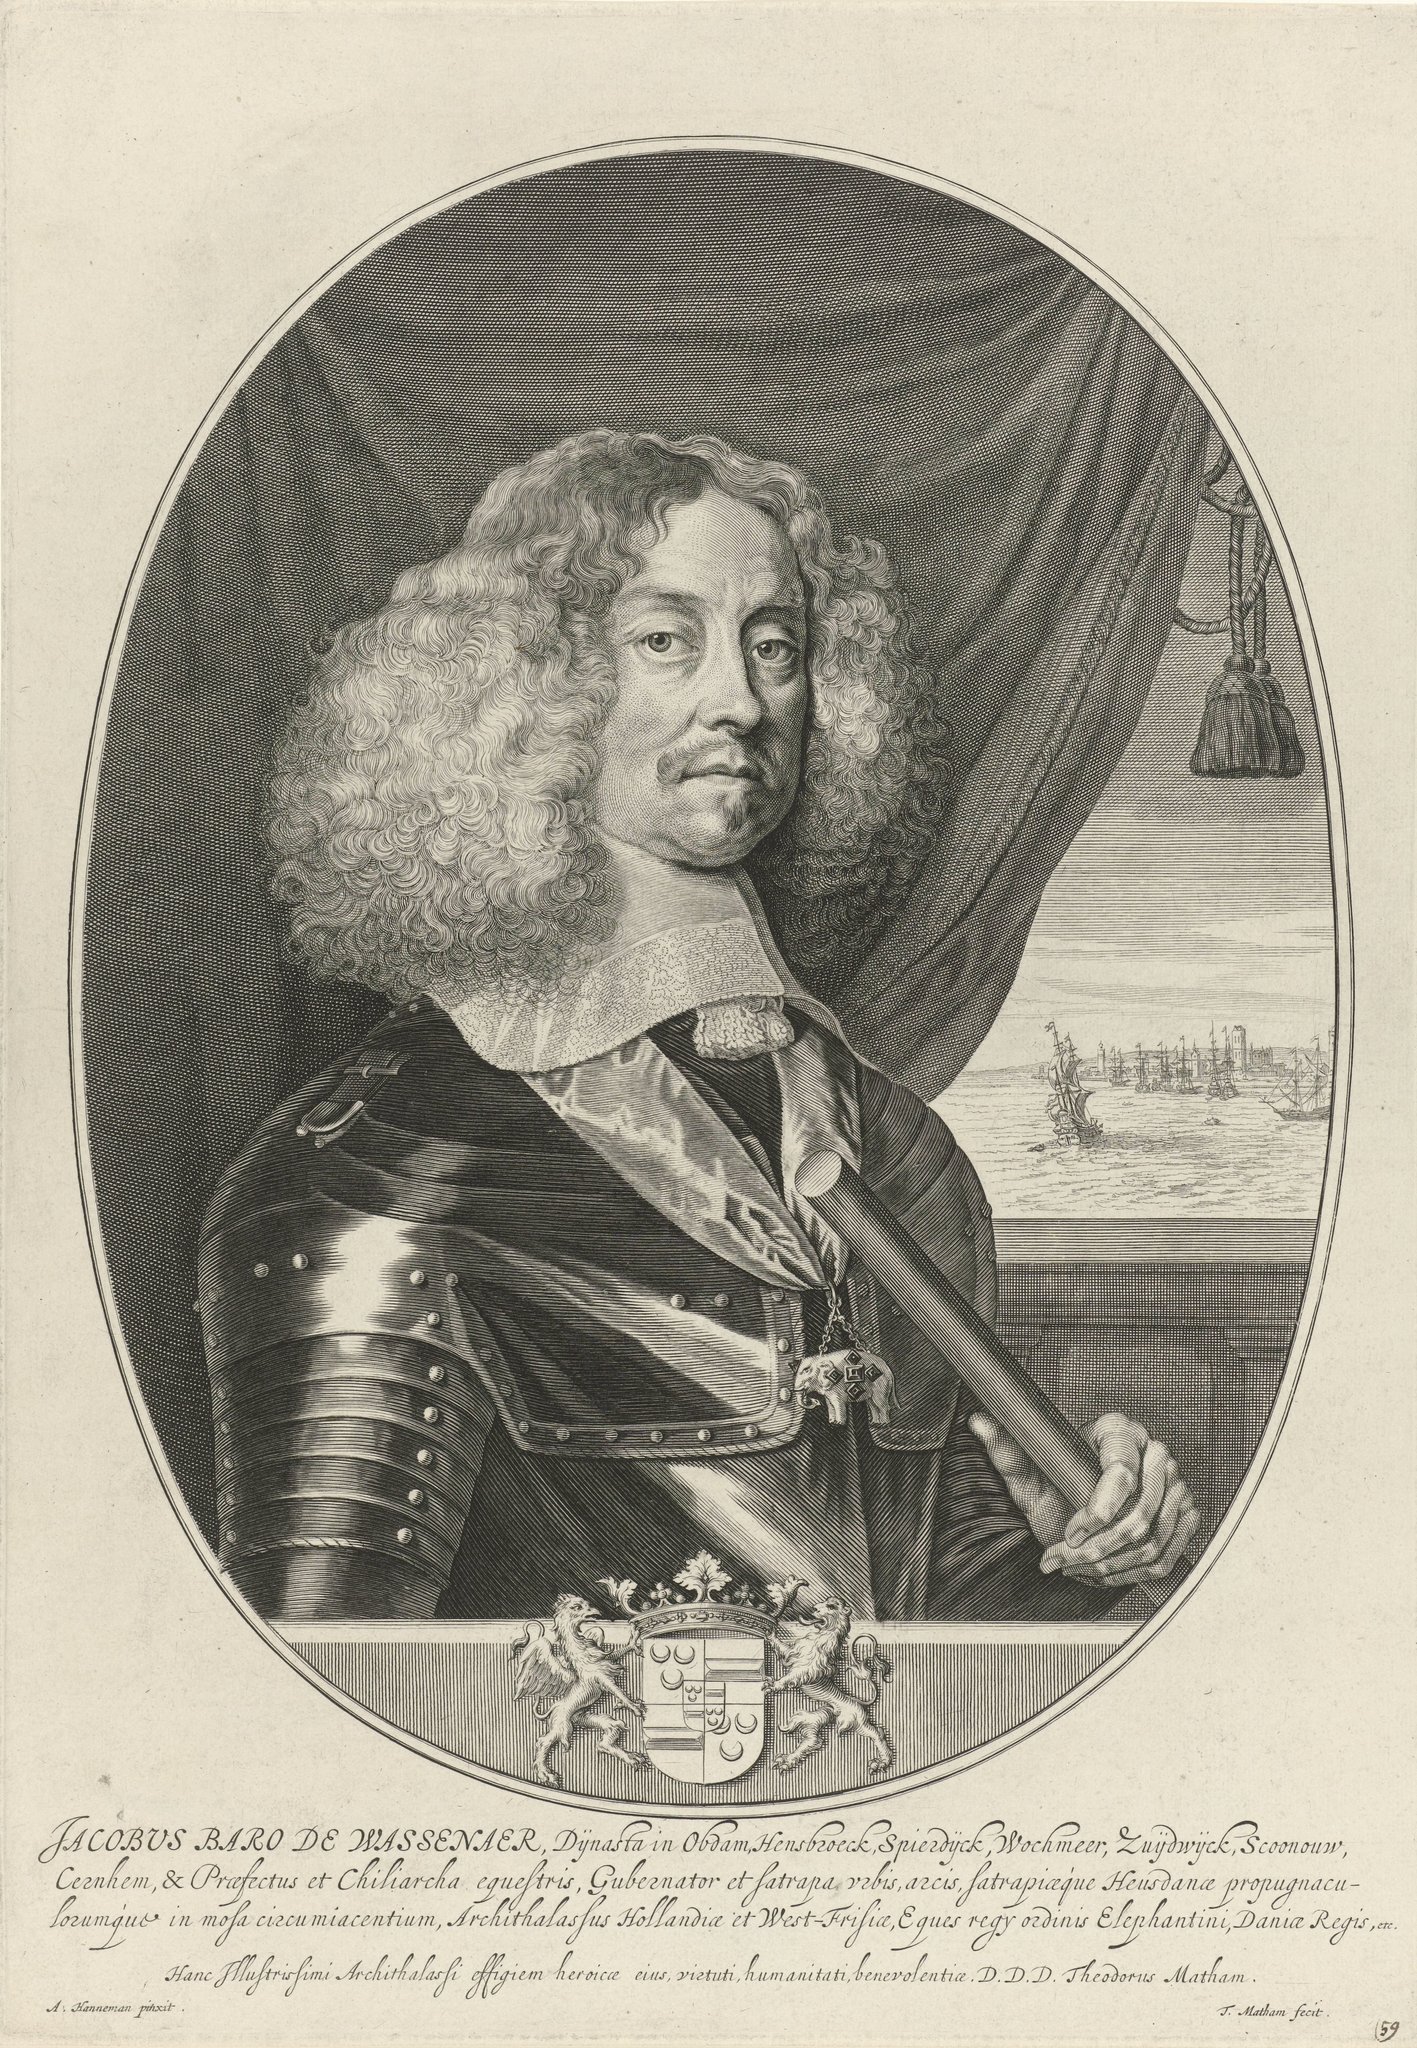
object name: print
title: Portret van Jacob baron van Wassenaer heer van Obdam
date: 1658-1676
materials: paper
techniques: engraving, etching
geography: northern netherlands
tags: jacob baron van wassenaer heer van obdam, knighthood order, baton of general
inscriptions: number: ‘59’, collector's mark: Lugt 2228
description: Portret van Jacob baron van Wassenaer heer van Obdam, als admiraal, met in zijn hand een commandostaf en om zijn hals het teken van de Deense Orde van de Olifant. Op de achtergrond zijn vloot. Middenonder zijn wapen.